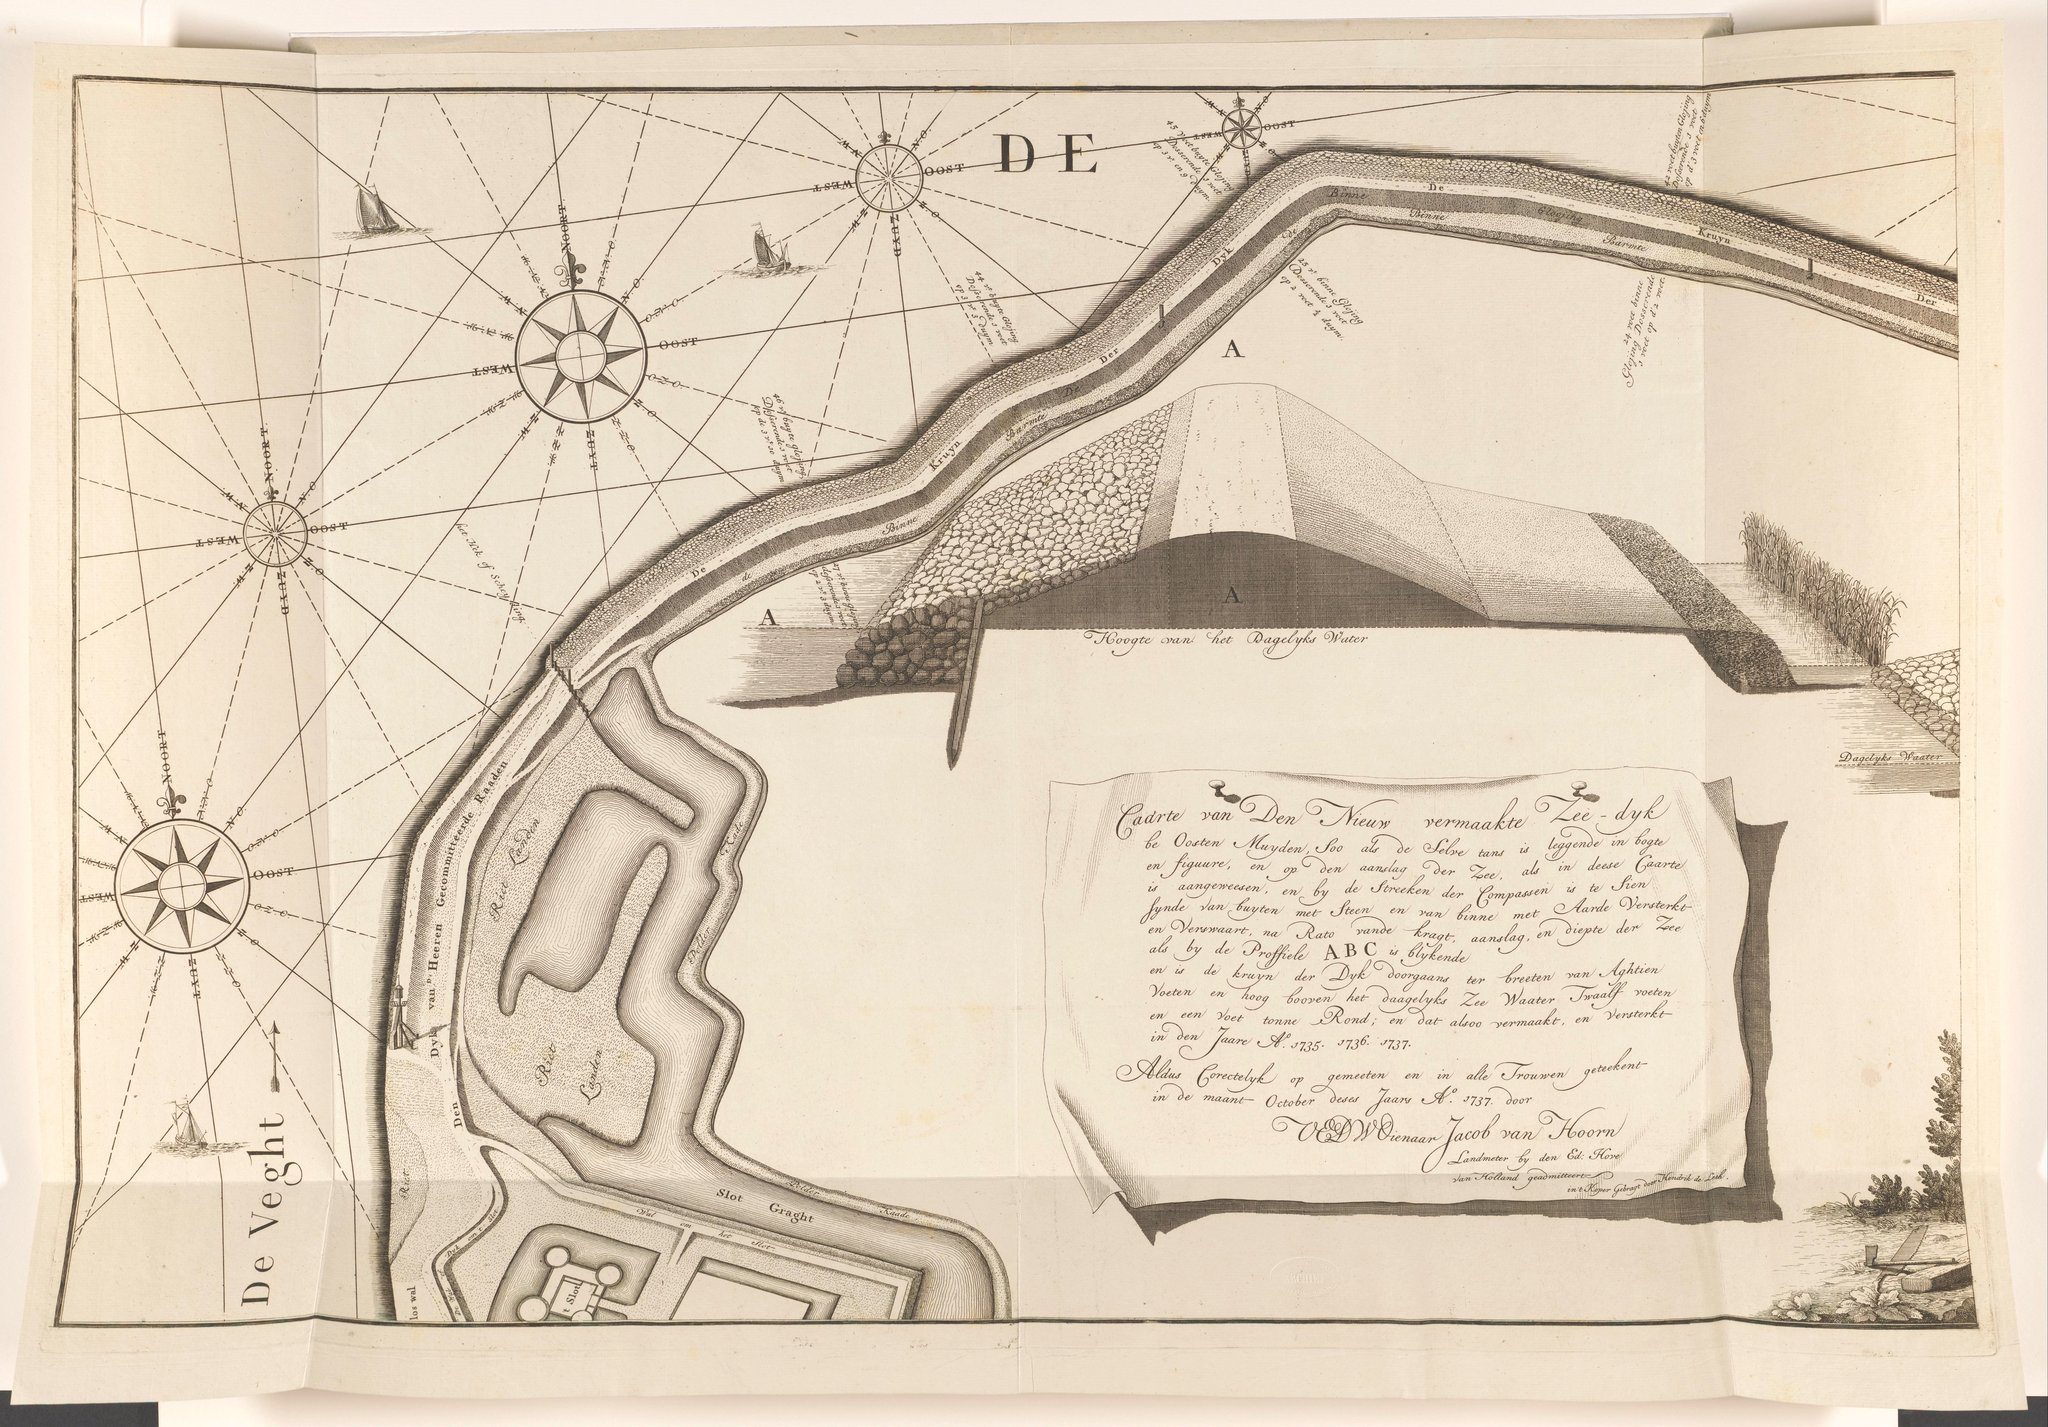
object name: print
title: Caarte van den nieuw vermaakte zee-dyk be oosten Muyden, soo als de selve tans is leggende in bogte en figuure, en op den aanslag der zee …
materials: paper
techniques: engraving, etching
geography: amsterdam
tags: maps of separate countries or regions, dikes, levee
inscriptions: check stamp: ‘Archief Ministerie van Oorlog Afdeeling Genie’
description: Linkerdeel van een kaart van de zeedijk bij Muiden.